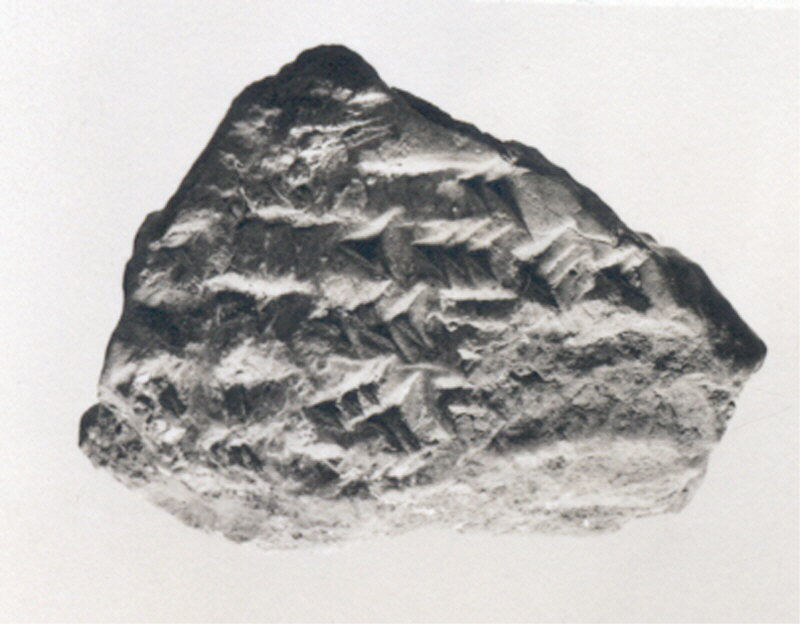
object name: cuneiform tablet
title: Cuneiform tablet: fragment of a table of reciprocals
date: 333-1 BCE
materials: clay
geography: mesopotamia